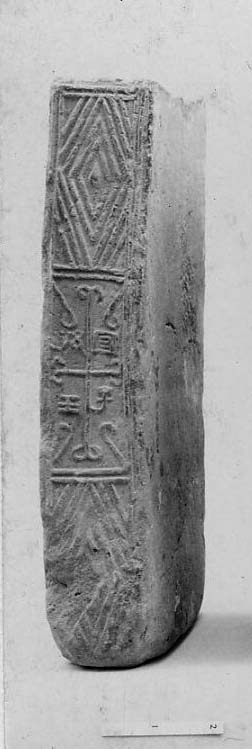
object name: tile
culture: chinese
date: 221 BCE-220 CE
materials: earthenware